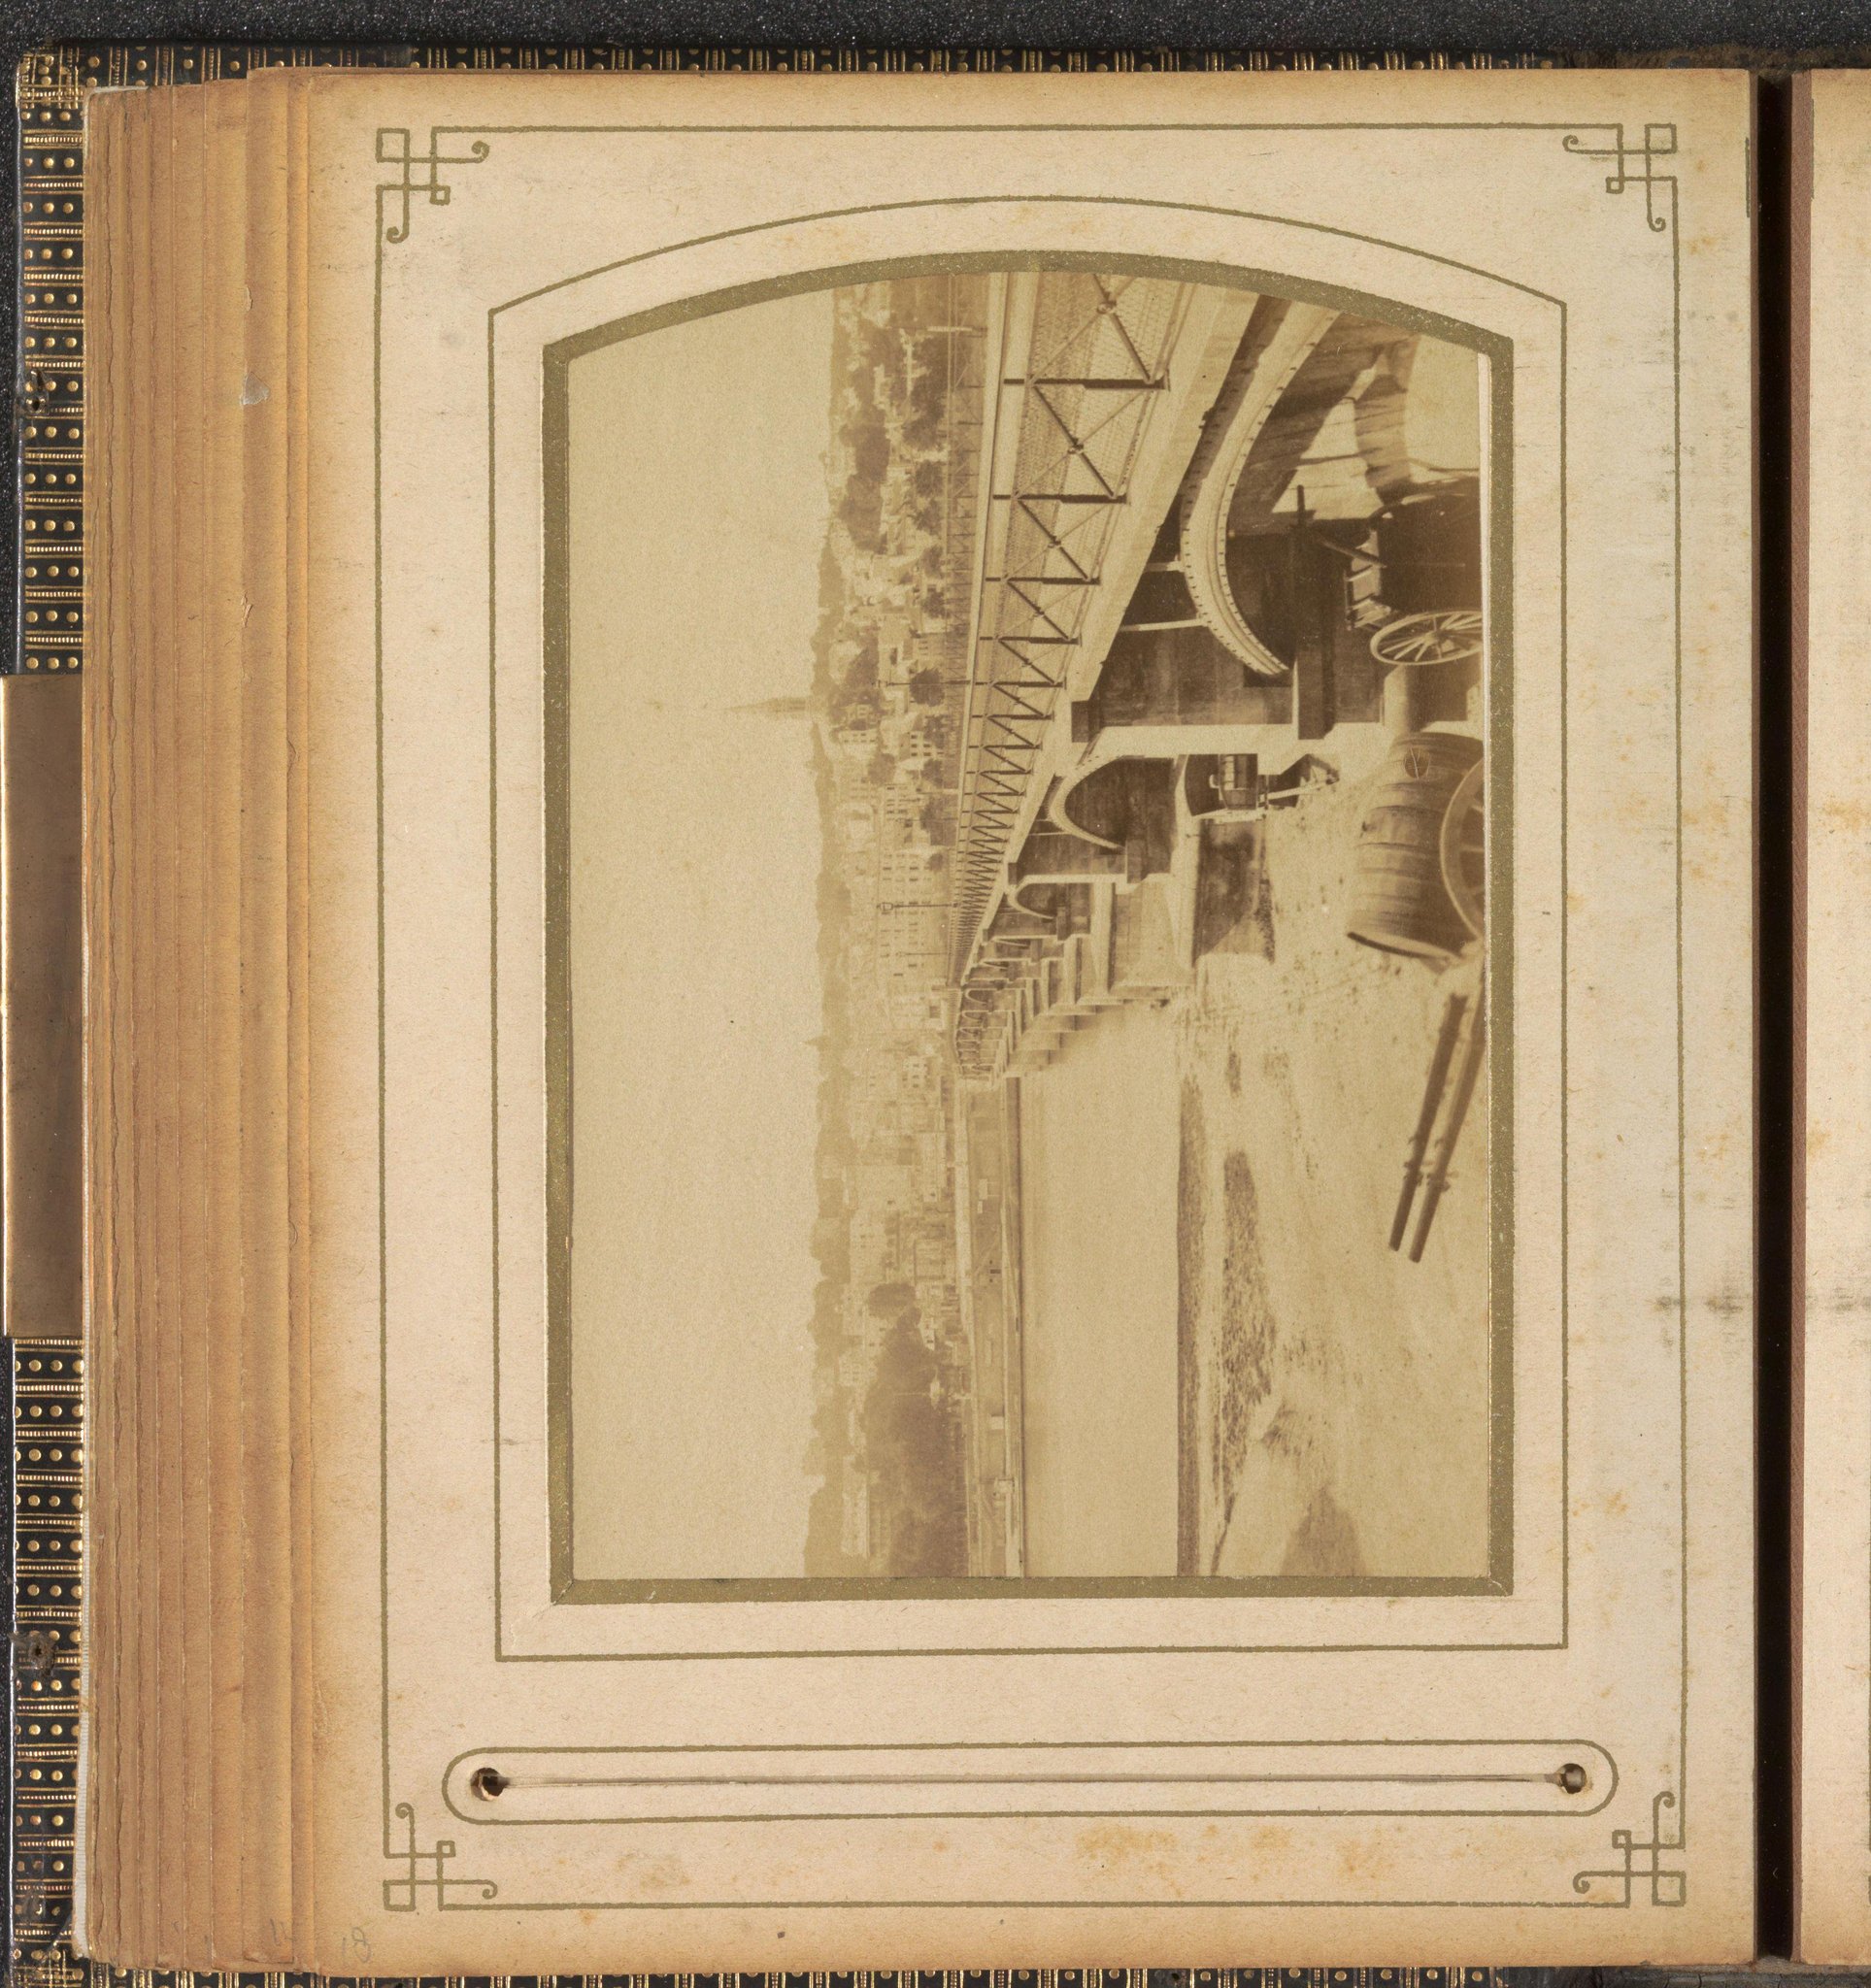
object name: photograph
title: Brug in Parijs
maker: Anonymous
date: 1870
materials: cardboard, paper, photographic support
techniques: albumen print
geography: paris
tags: wooden container: barrel, cask, bucket, bridge in city across river, canal, etc., paris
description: Onderdeel van Fotoalbum met kabinetfoto's van bezienswaardigheden in Parijs.